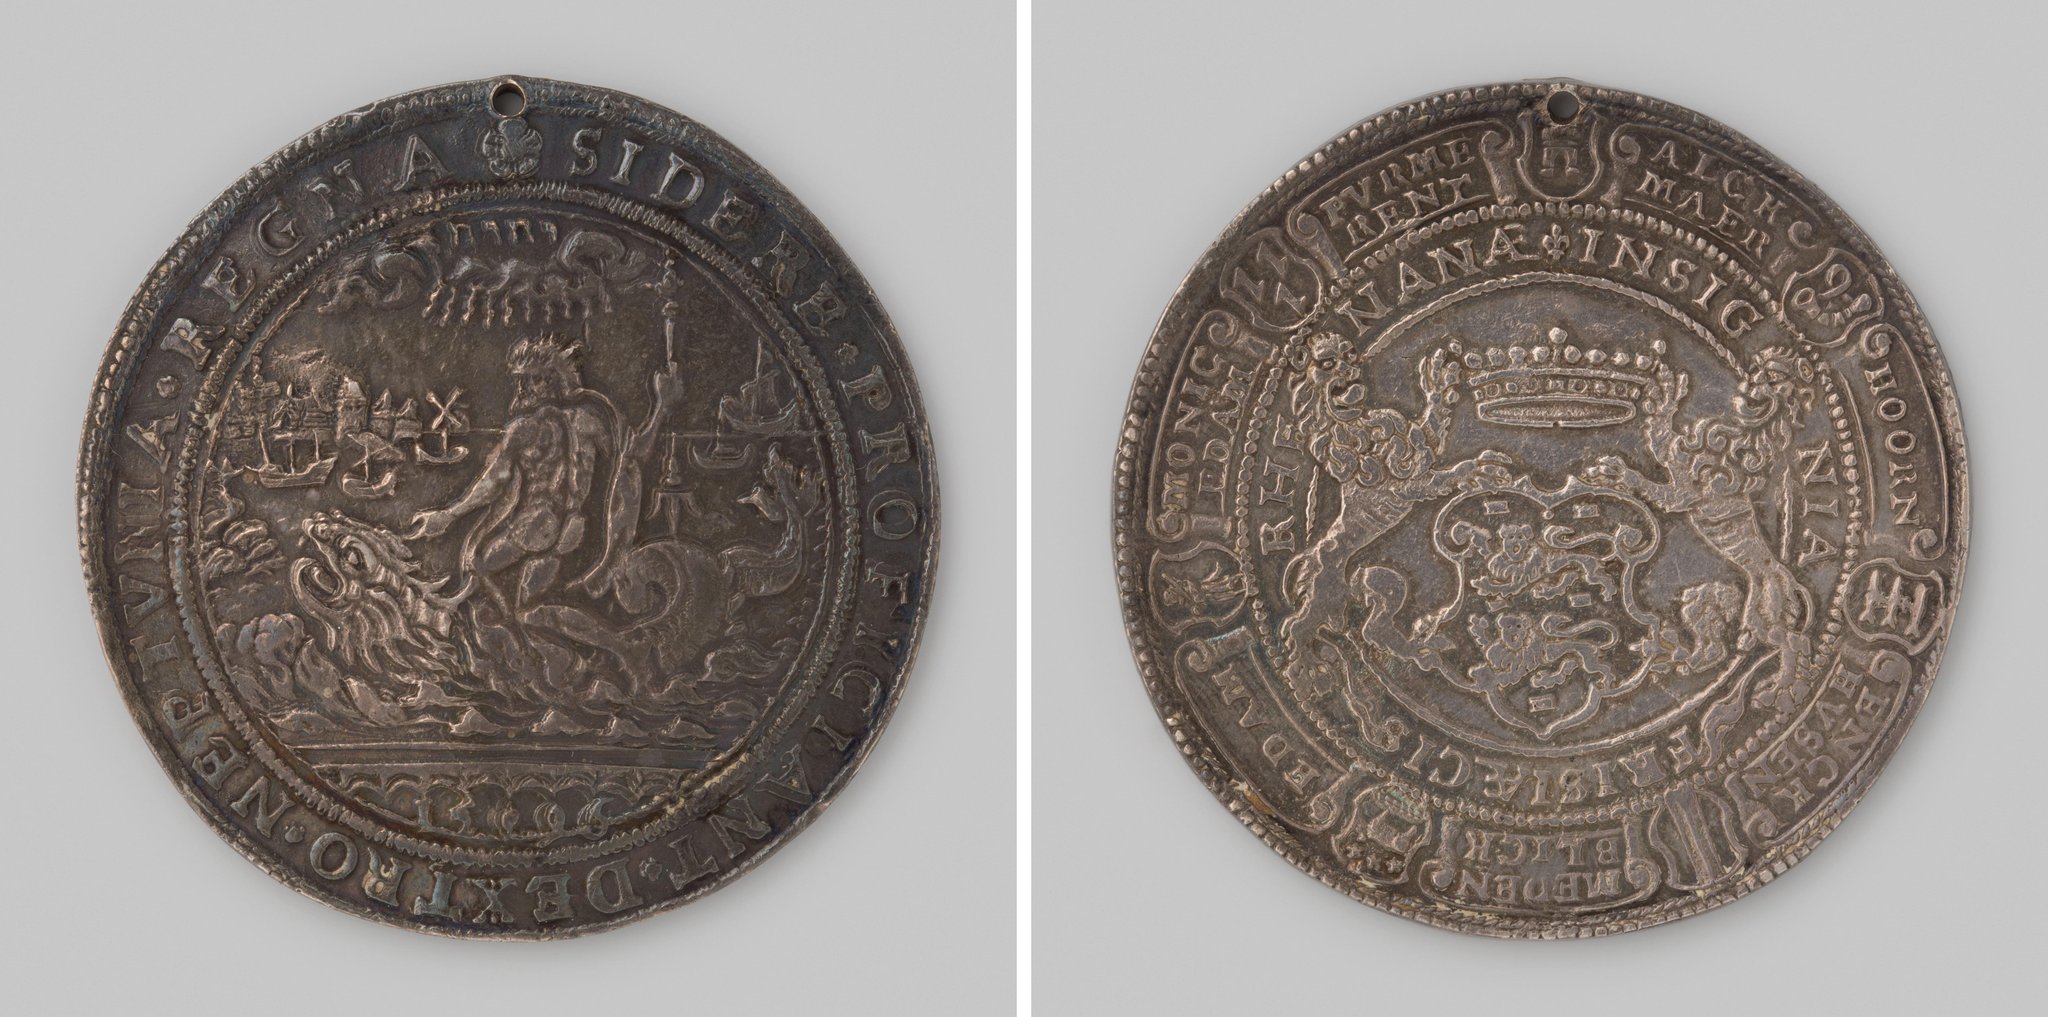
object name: history medal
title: Voorspoedige scheepvaart in de Nederlanden 1596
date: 1596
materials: silver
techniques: striking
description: Zilveren penning, op de voorzijde Neptunus die op een dolfijn langs de kust vaart, met omschrift, op de keerzijde het gekroonde Westfriese wapenschild met leeuwen als dragers, met omschrift, binnen een krans van zeven Westfriese stadsnamen en -wapens.